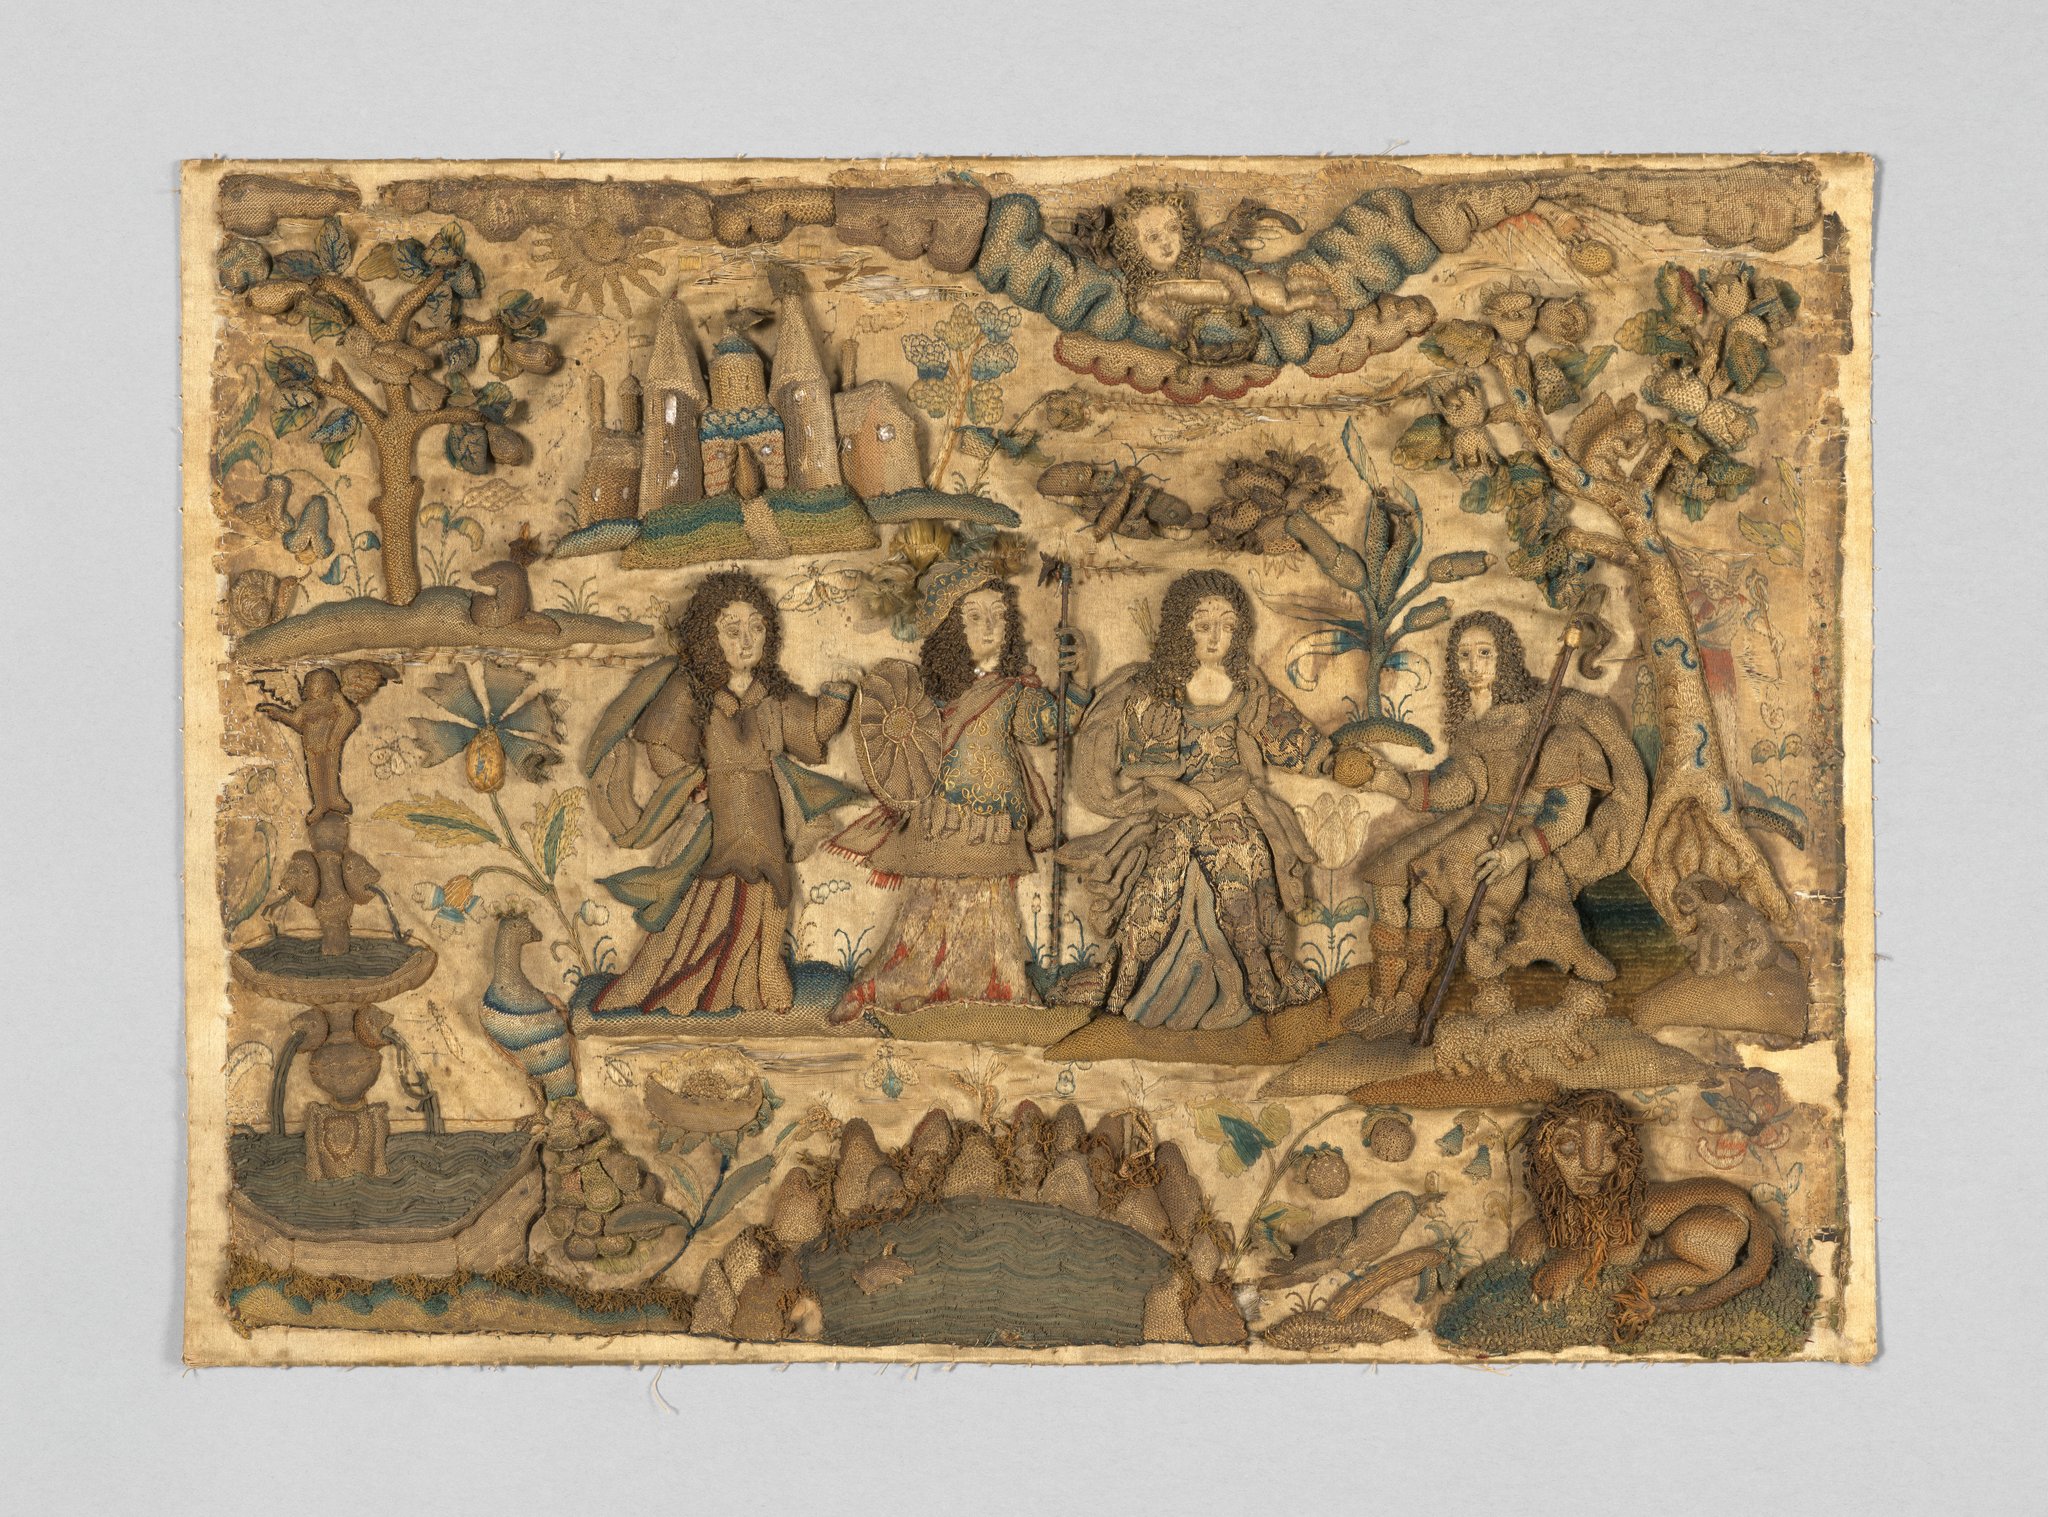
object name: panel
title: Panel with The Judgment of Paris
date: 1680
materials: silk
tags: men,women,peacocks,insects,lions